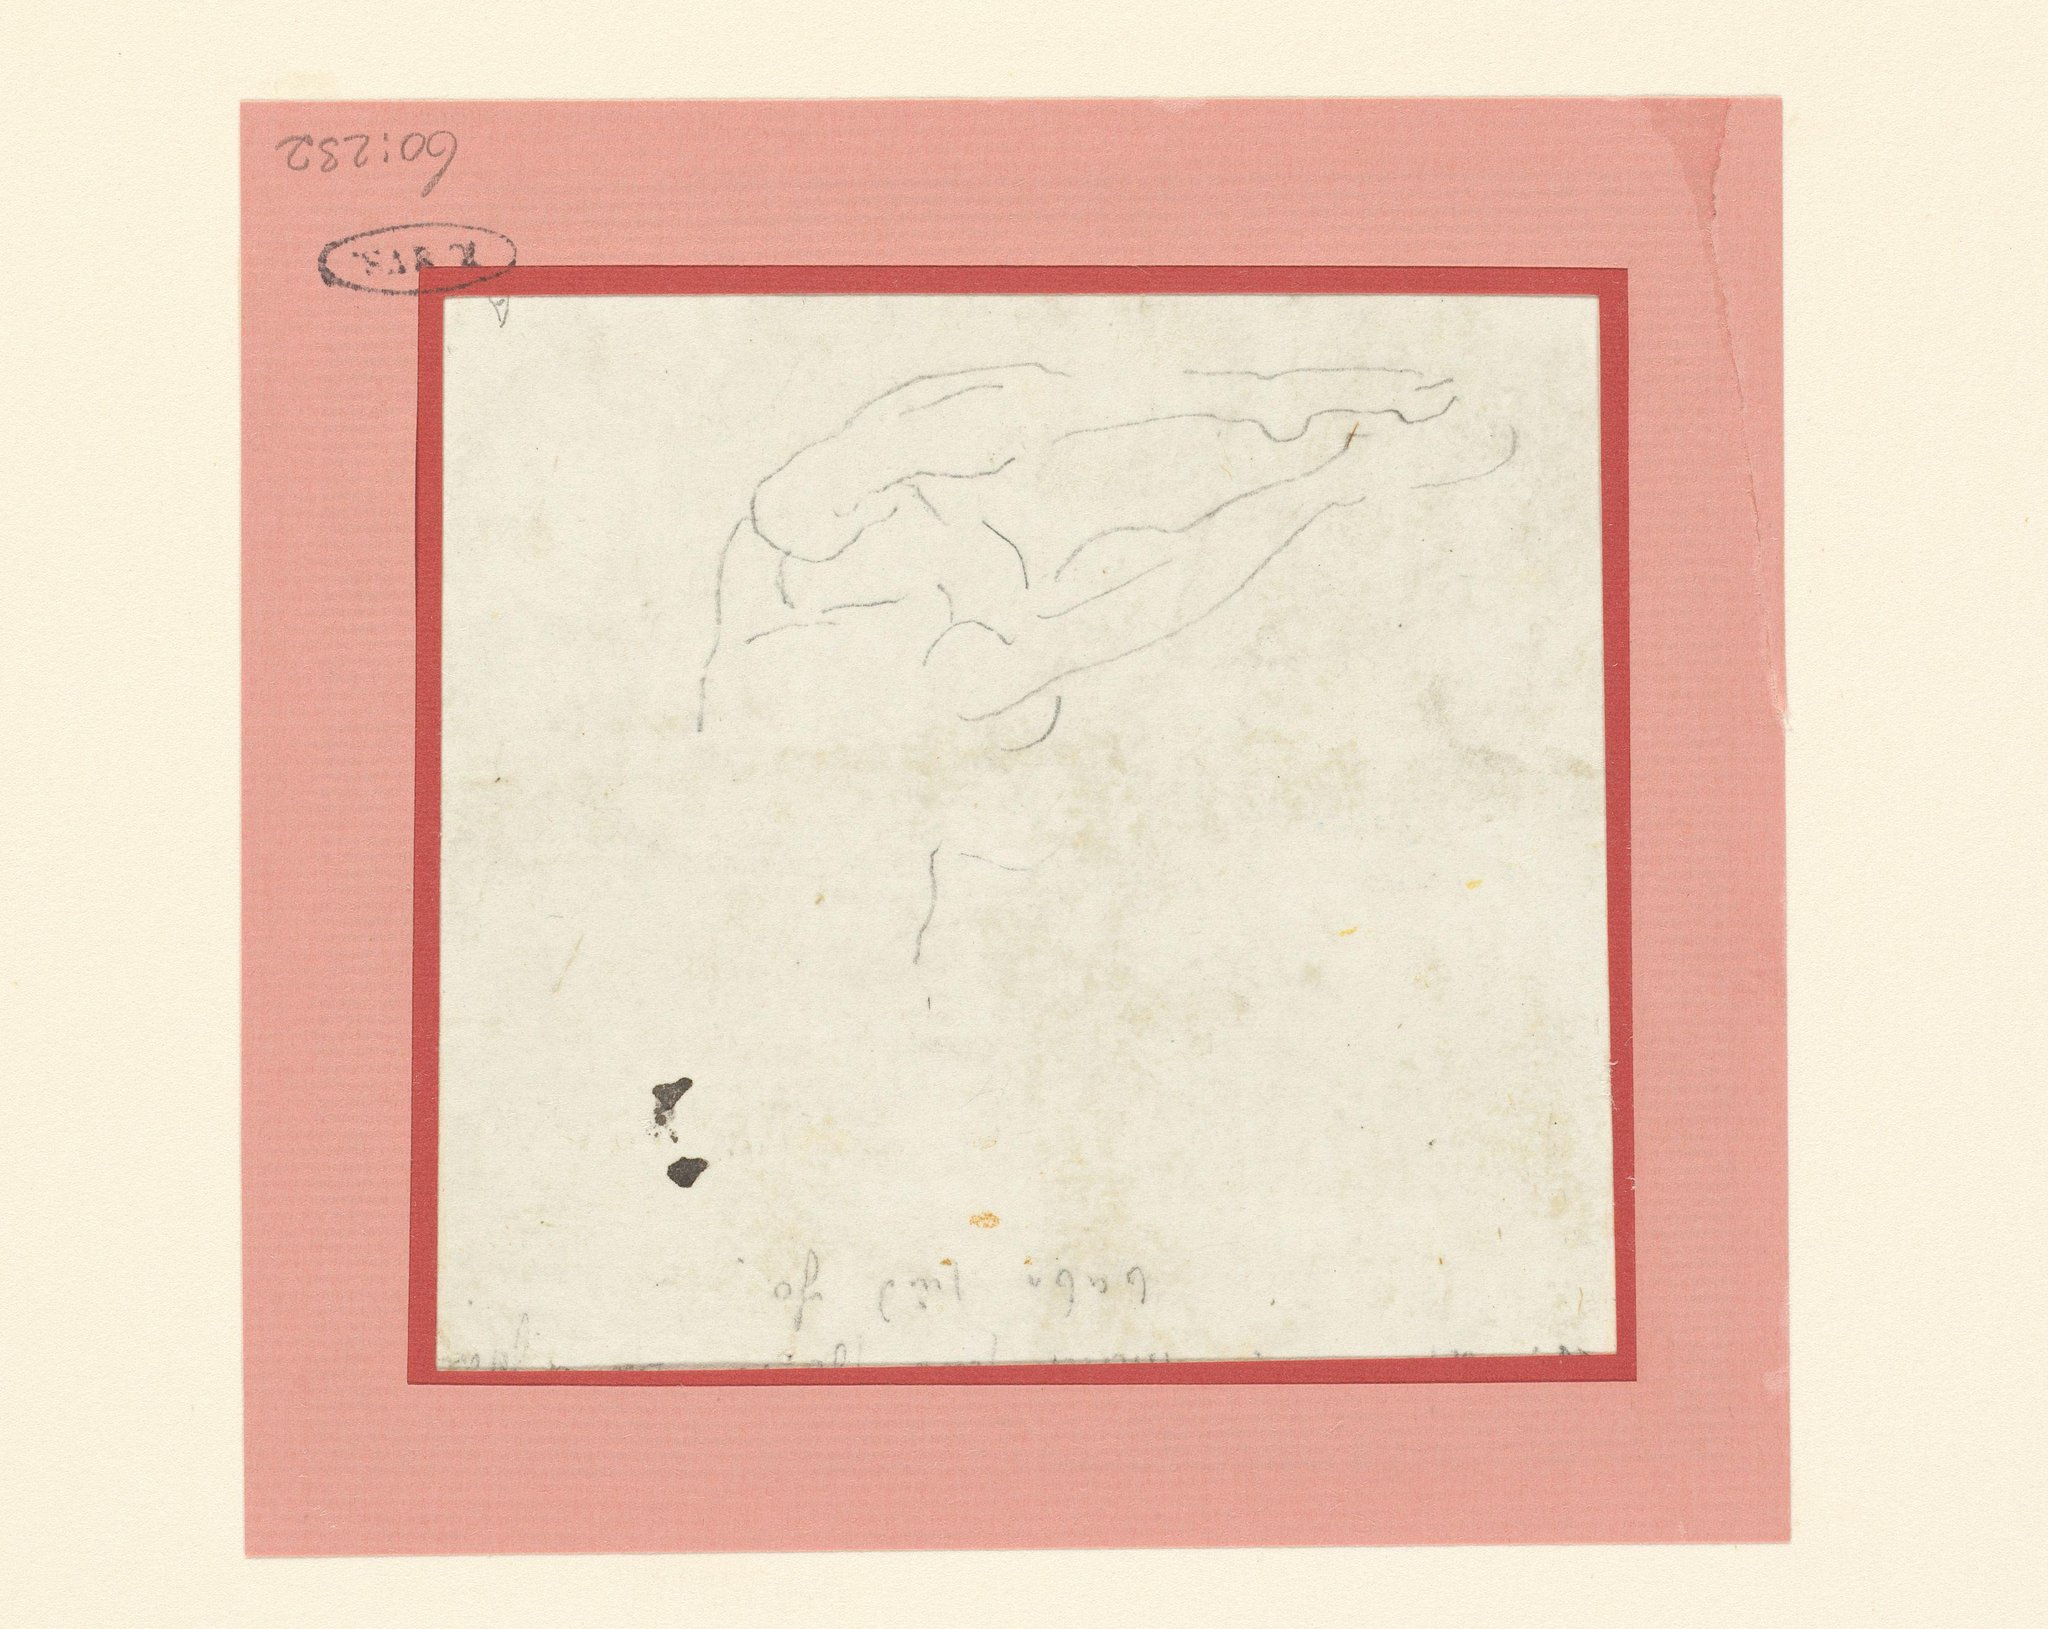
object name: design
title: Contouren van benen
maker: ferdinand hodler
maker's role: draughtsman, print maker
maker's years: 1853-1918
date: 1863-1911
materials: paper, pencil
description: Doorgetrokken contouren van de benen van "Die Erwackende" (Der Tag) op de recto. Ontwerp voor een prent.